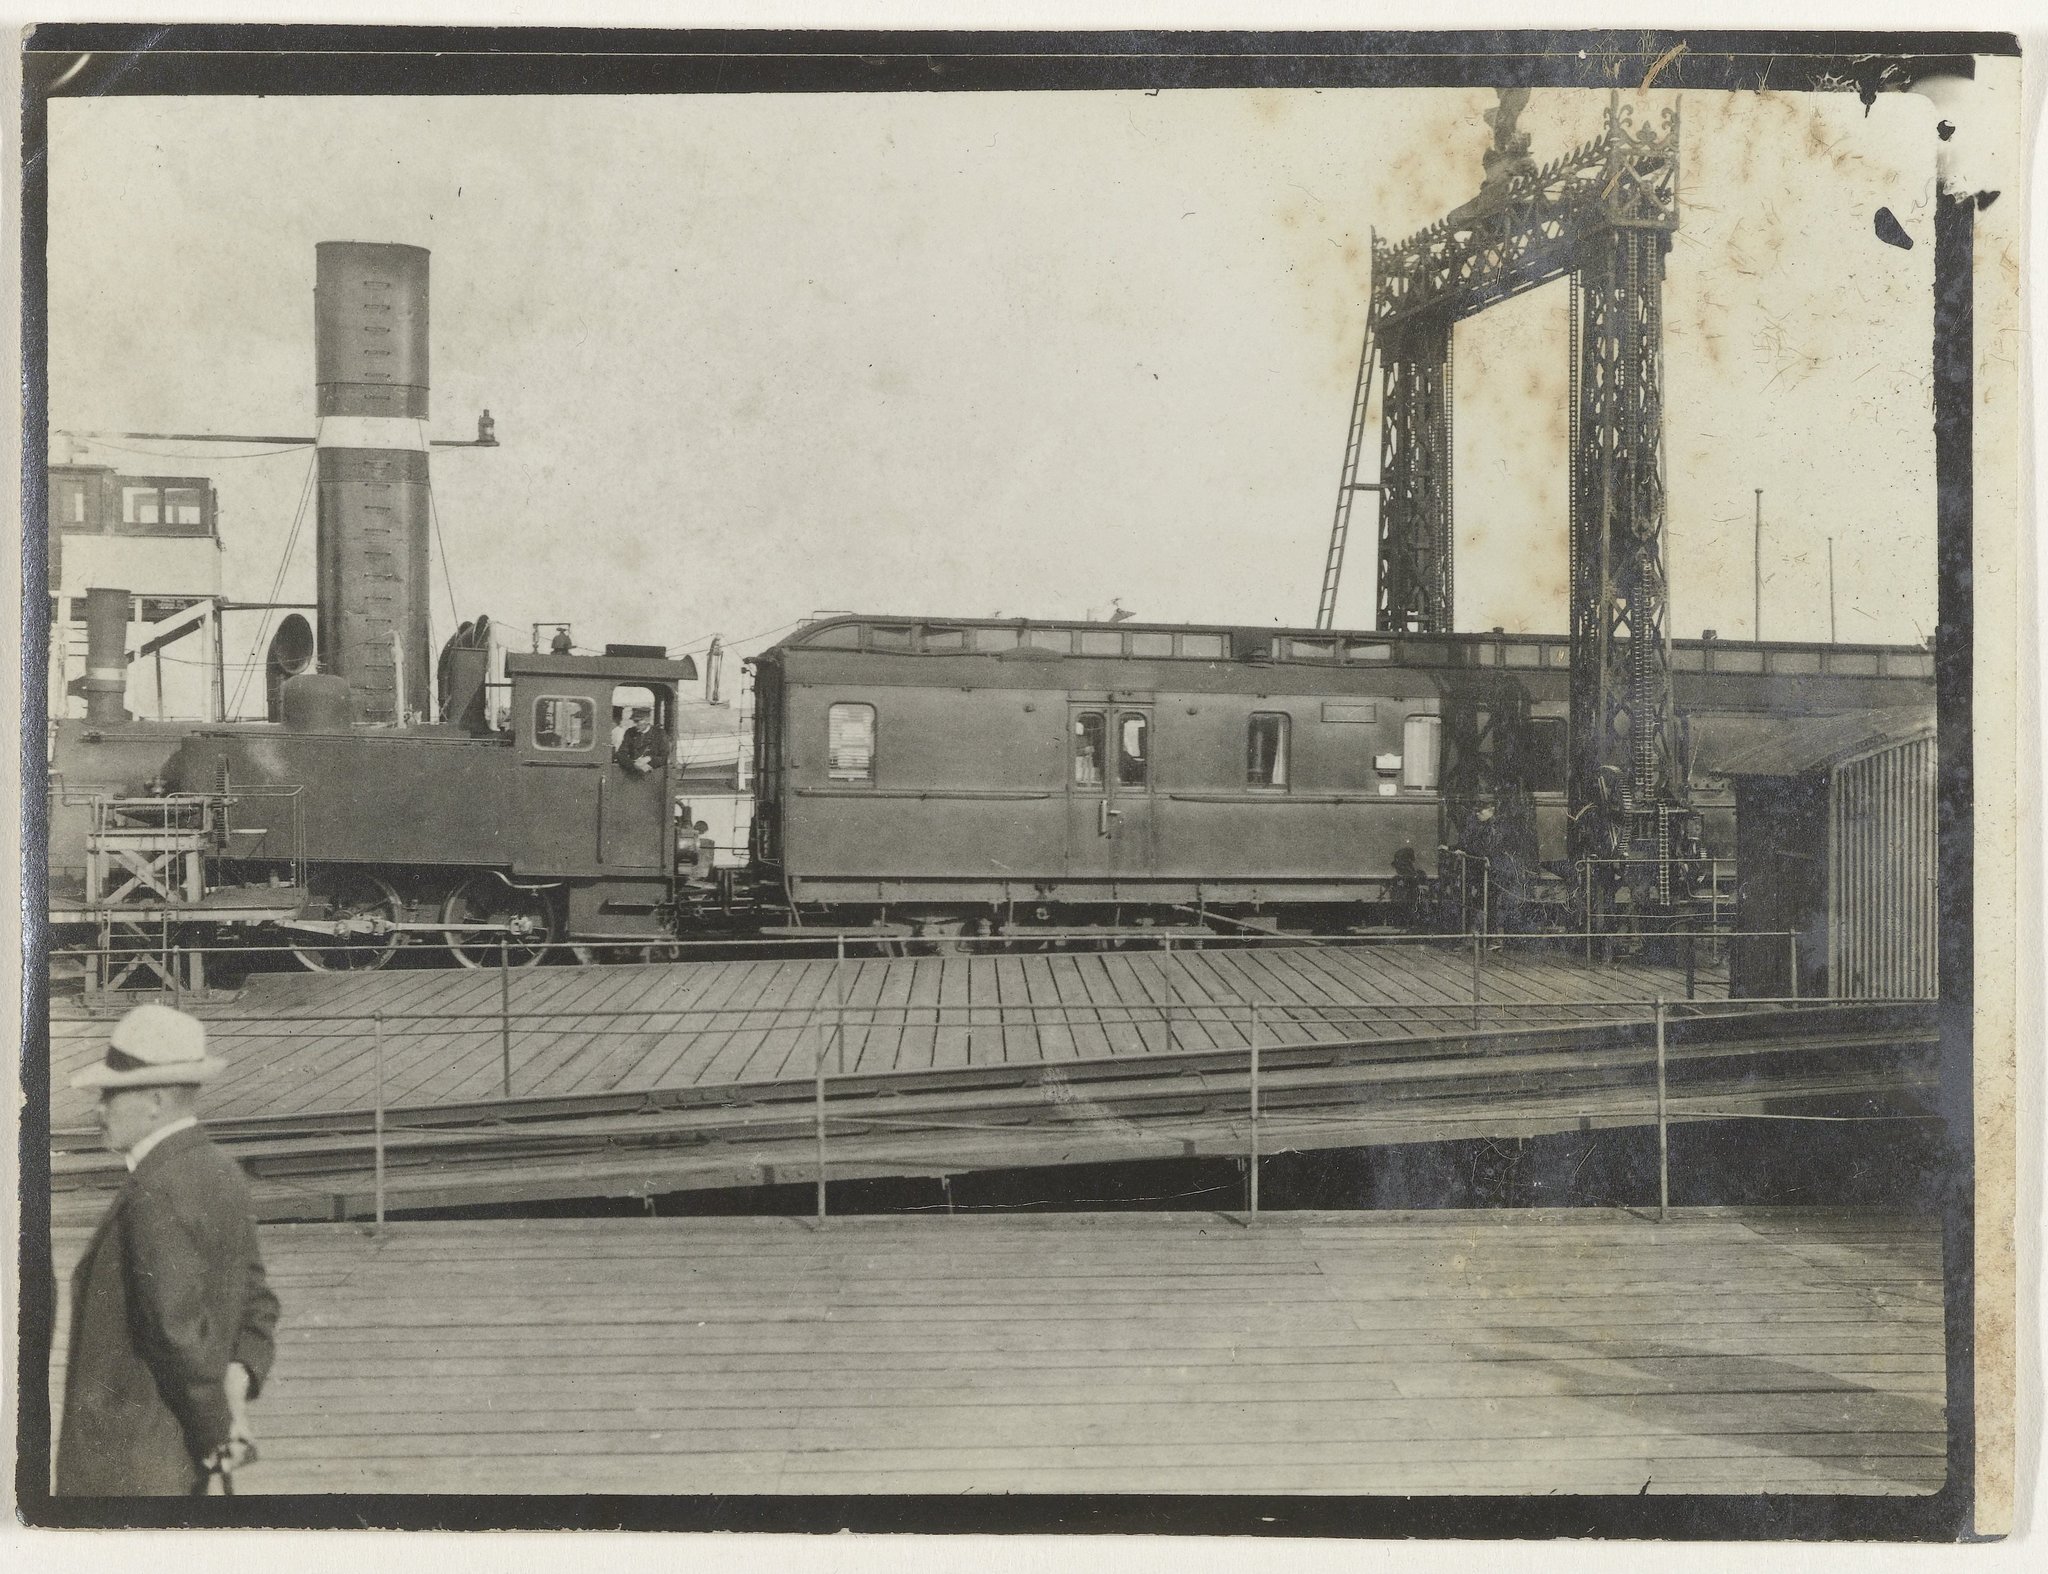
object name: photograph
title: Locomotief en trein op een spoorbrug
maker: Anonymous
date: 1900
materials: paper, photographic support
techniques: gelatin silver print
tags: station; shelter (railway, tramway), steam locomotive